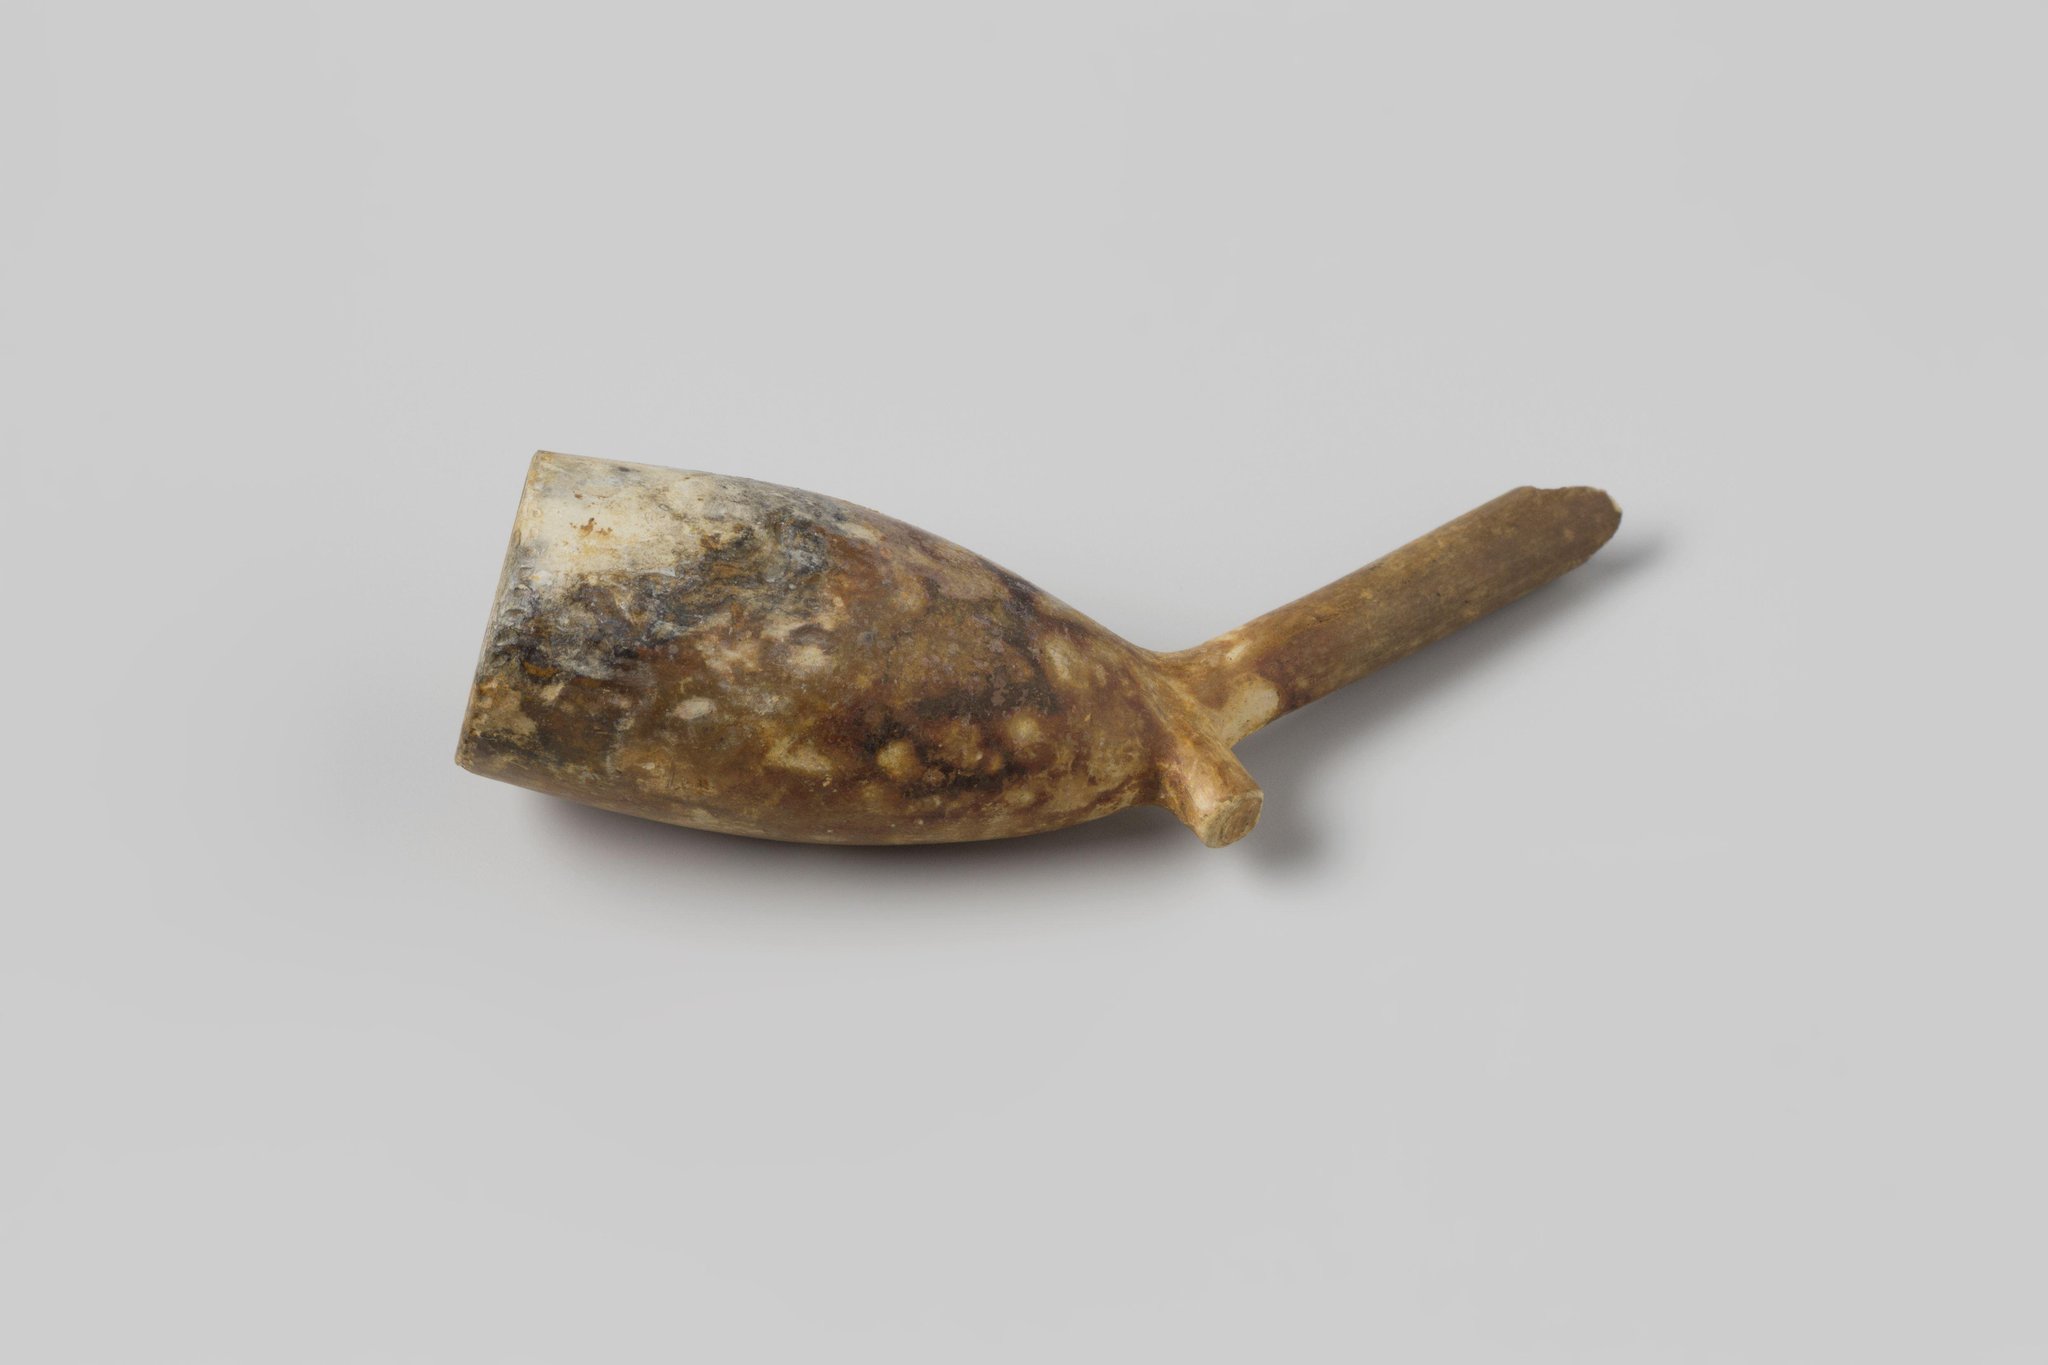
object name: pipe bowl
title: Pijpenkop met stuk steel uit het wrak van de Oost-Indiëvaarder Hollandia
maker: Anonymous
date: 1700-1743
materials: clay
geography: netherlands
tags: verenigde oostindische compagnie, hollandia (schip), annet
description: Pipe, bowl, heelmark: arched cage; (1) (5.1h), no hsm.